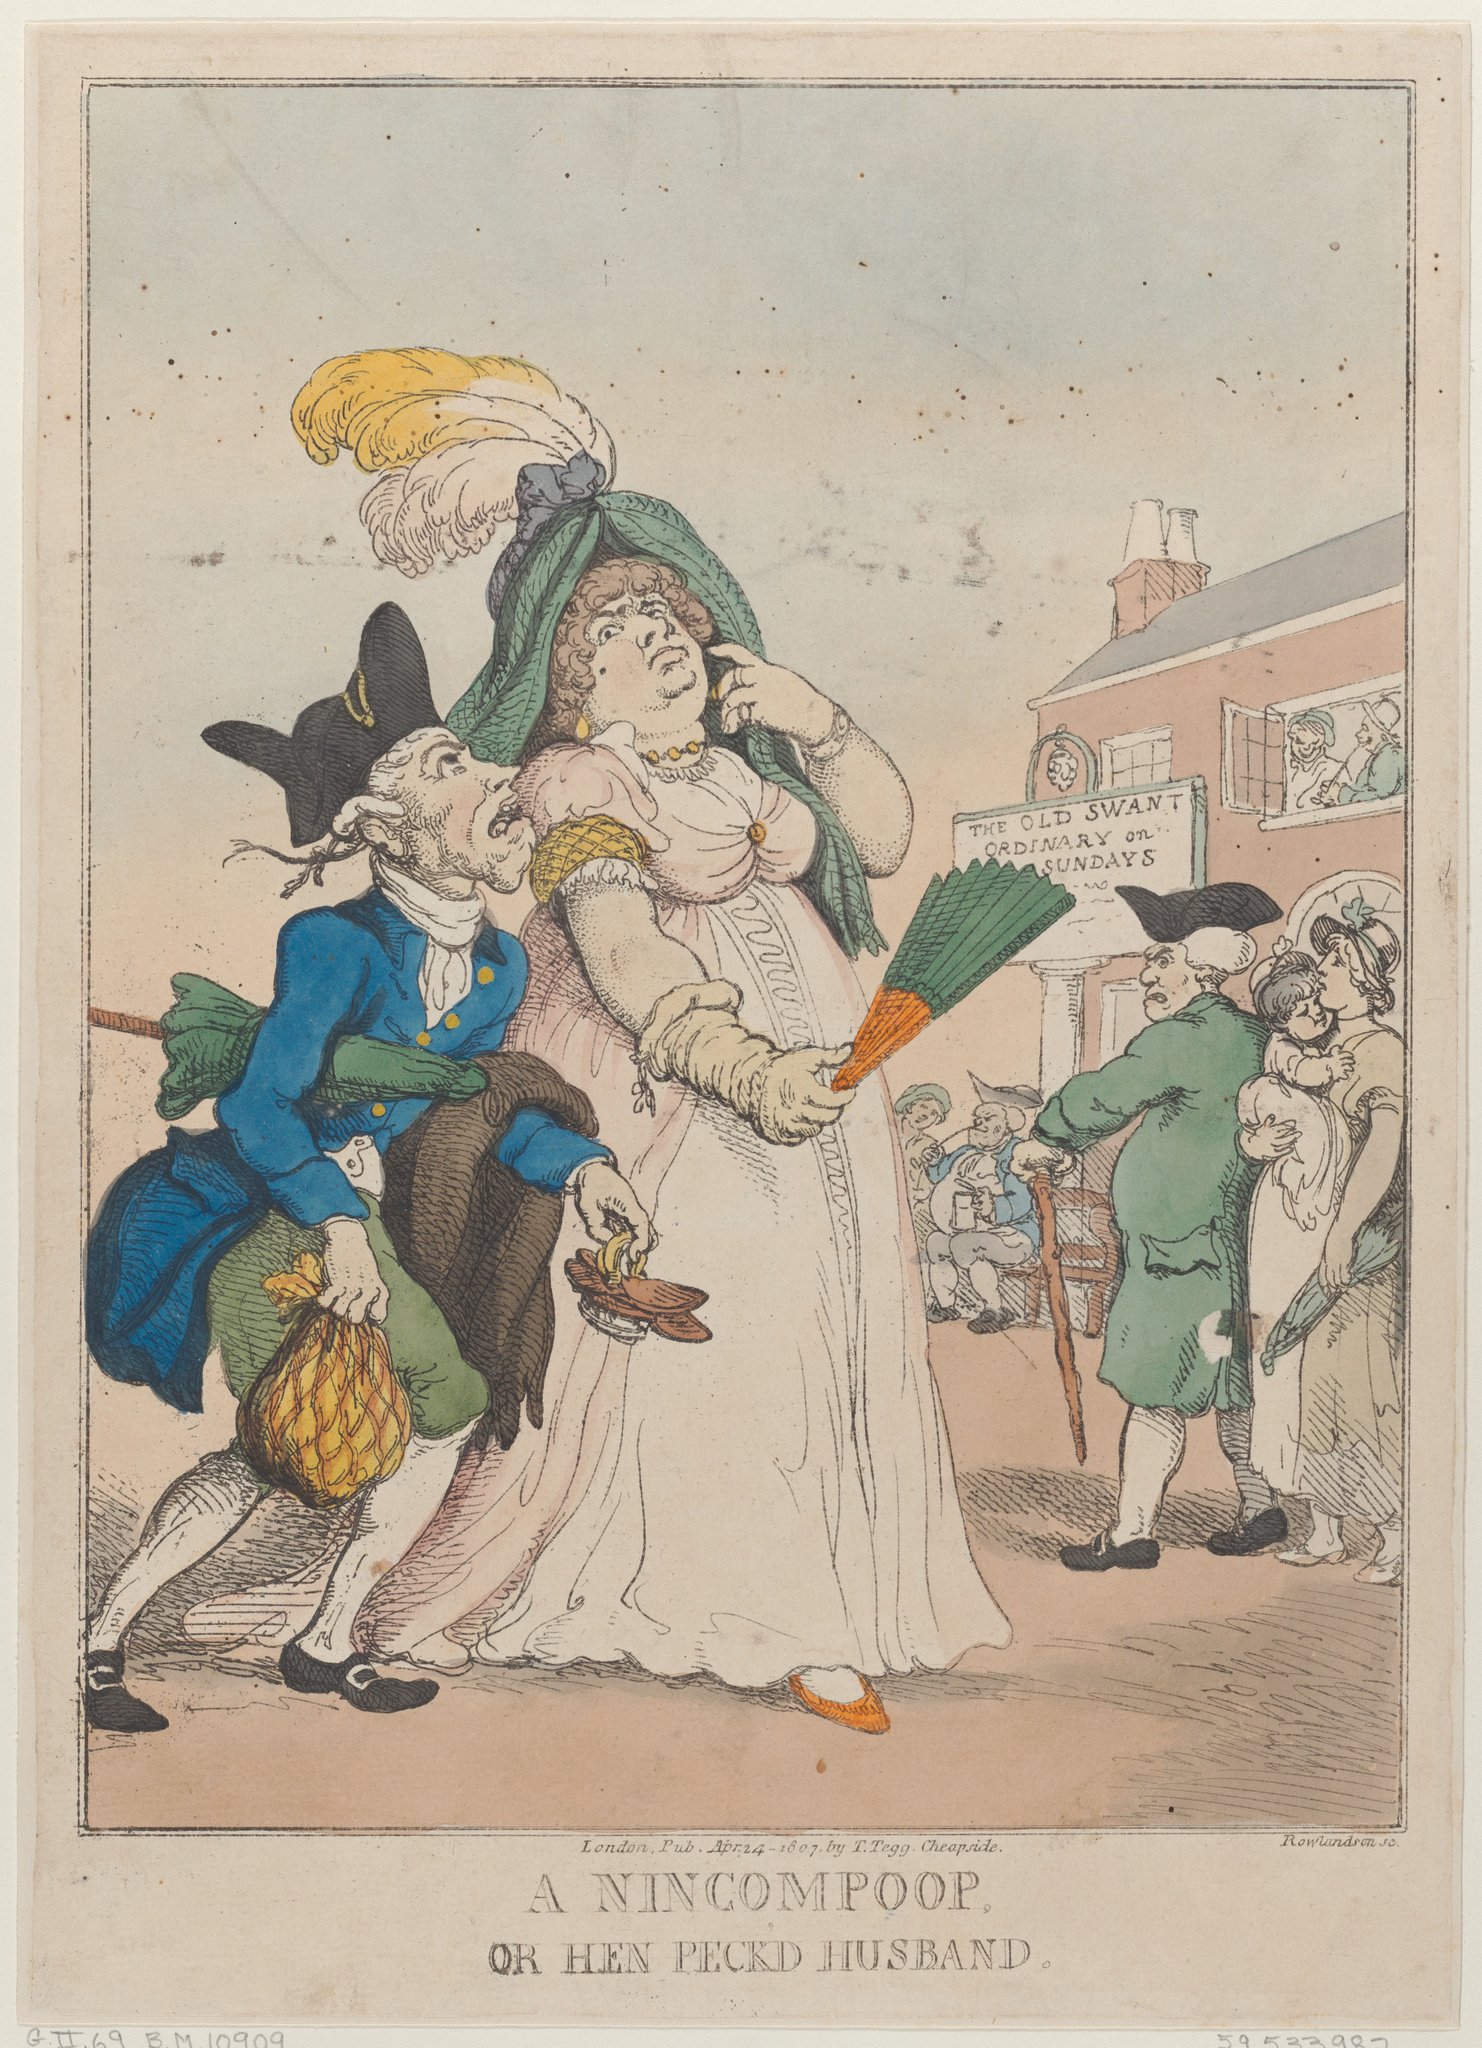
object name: print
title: A Nincompoop, or Hen Peck'd Husband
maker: thomas rowlandson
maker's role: artist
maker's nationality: british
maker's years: 1757-1827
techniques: etching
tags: satire,men,women